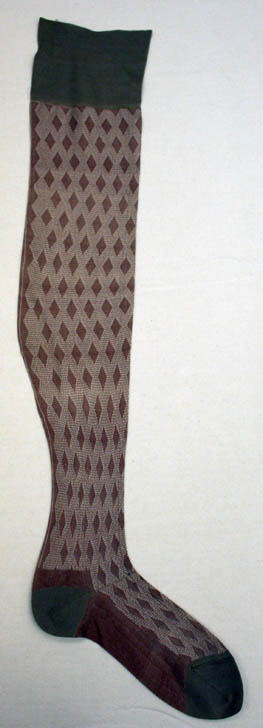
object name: stocking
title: Stockings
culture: american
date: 1890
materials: cotton